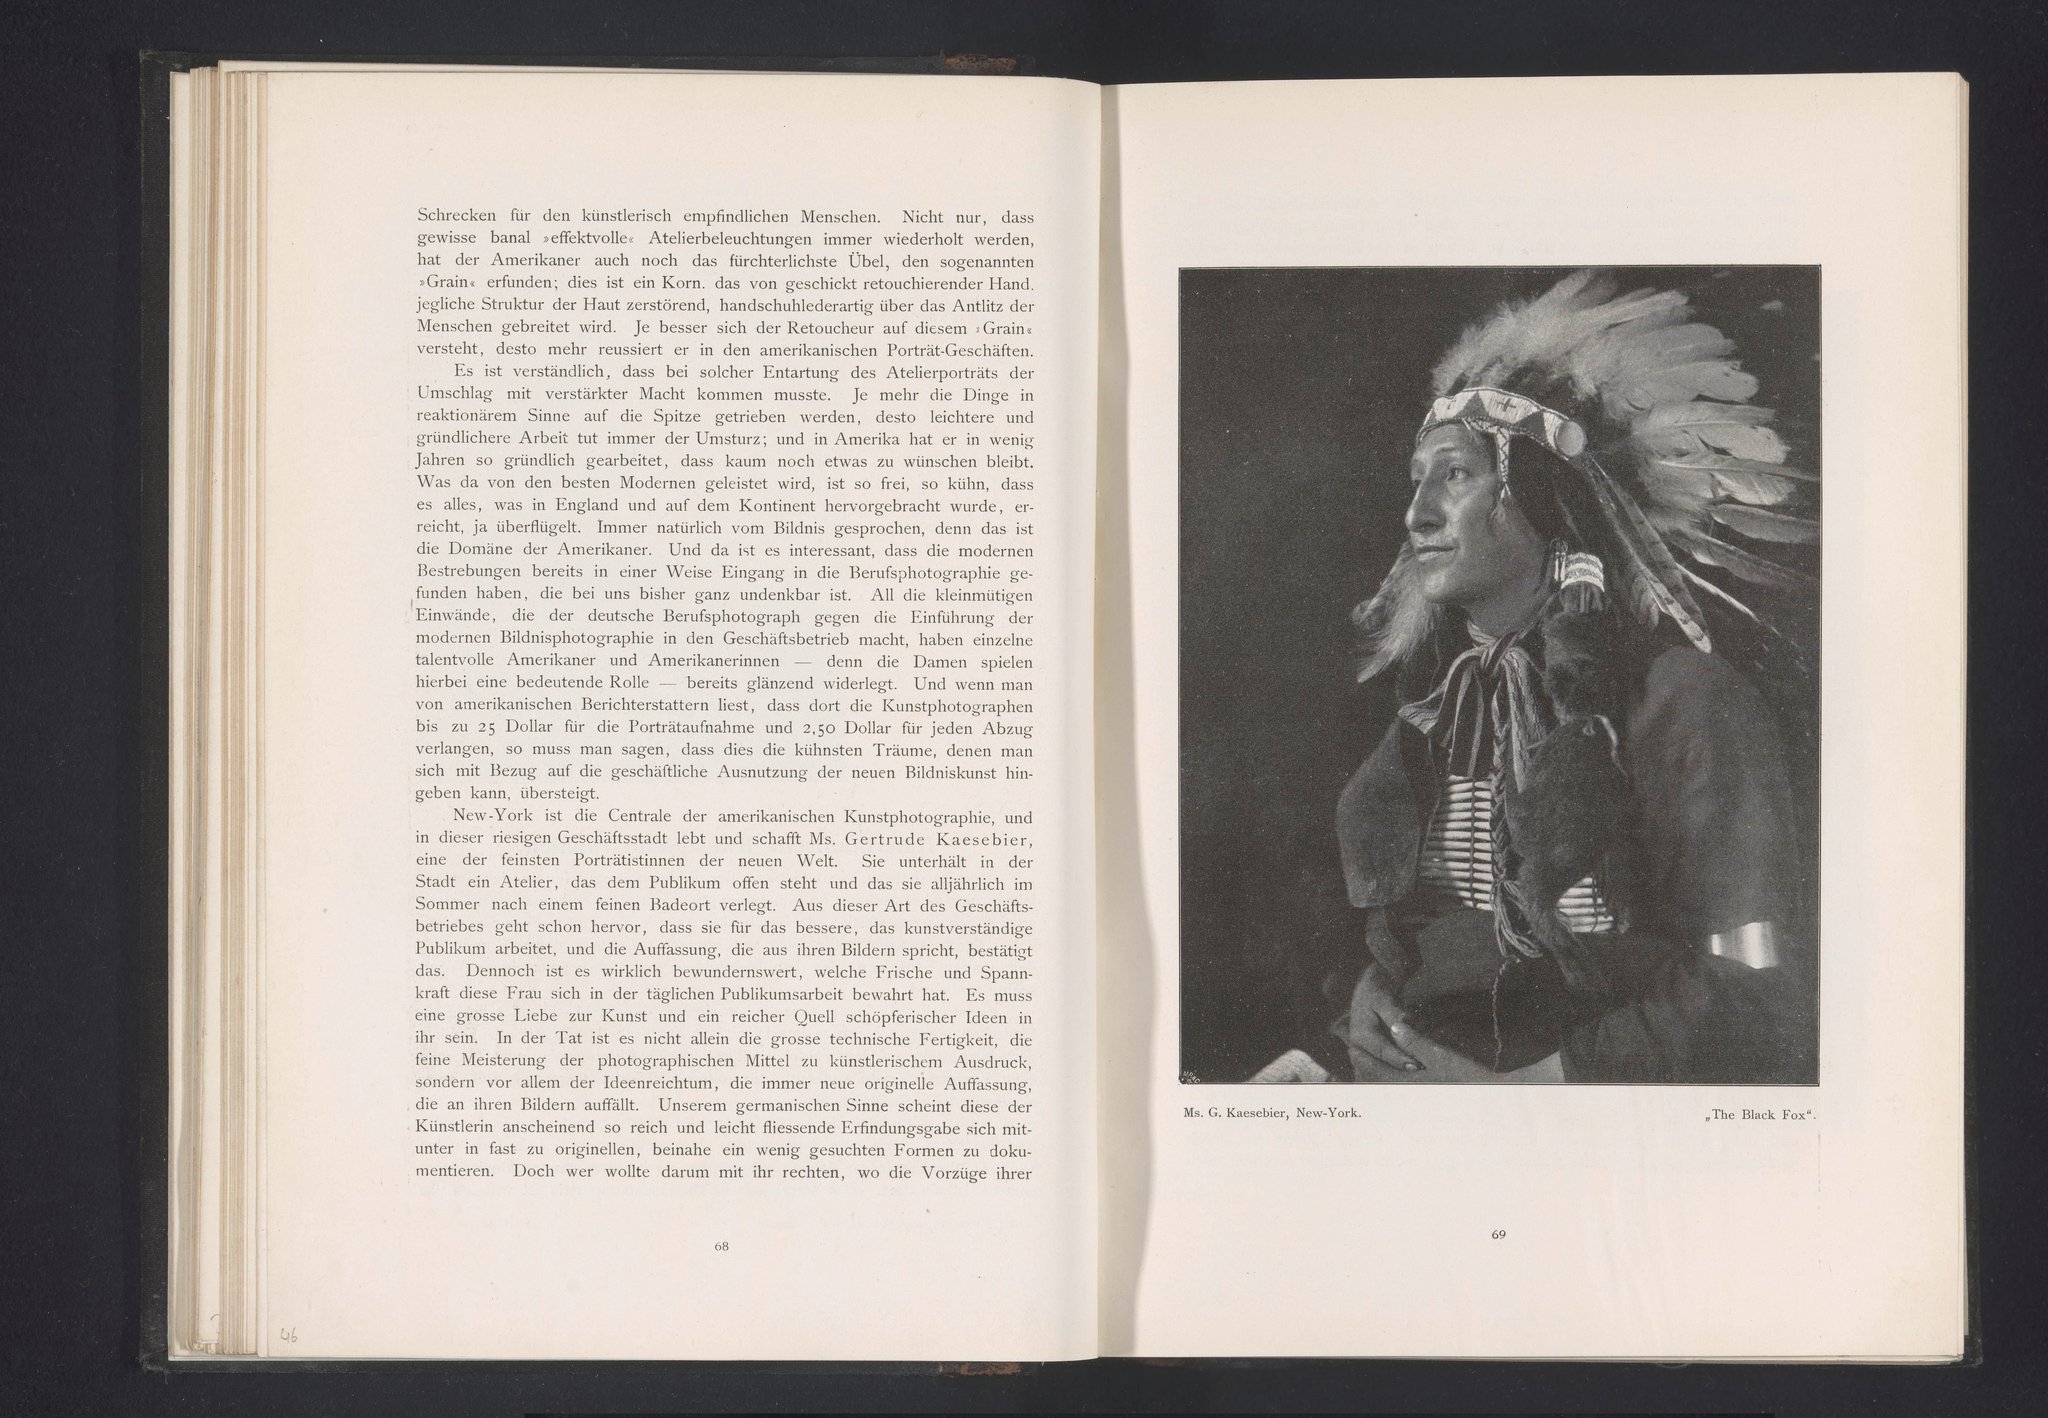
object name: photomechanical print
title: Portret van een onbekende man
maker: gertrude käsebier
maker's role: fotograaf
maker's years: 1852-1934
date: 1898-1903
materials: paper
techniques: autotype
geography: new york city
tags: historical persons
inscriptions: monogram: ‘MR&C’